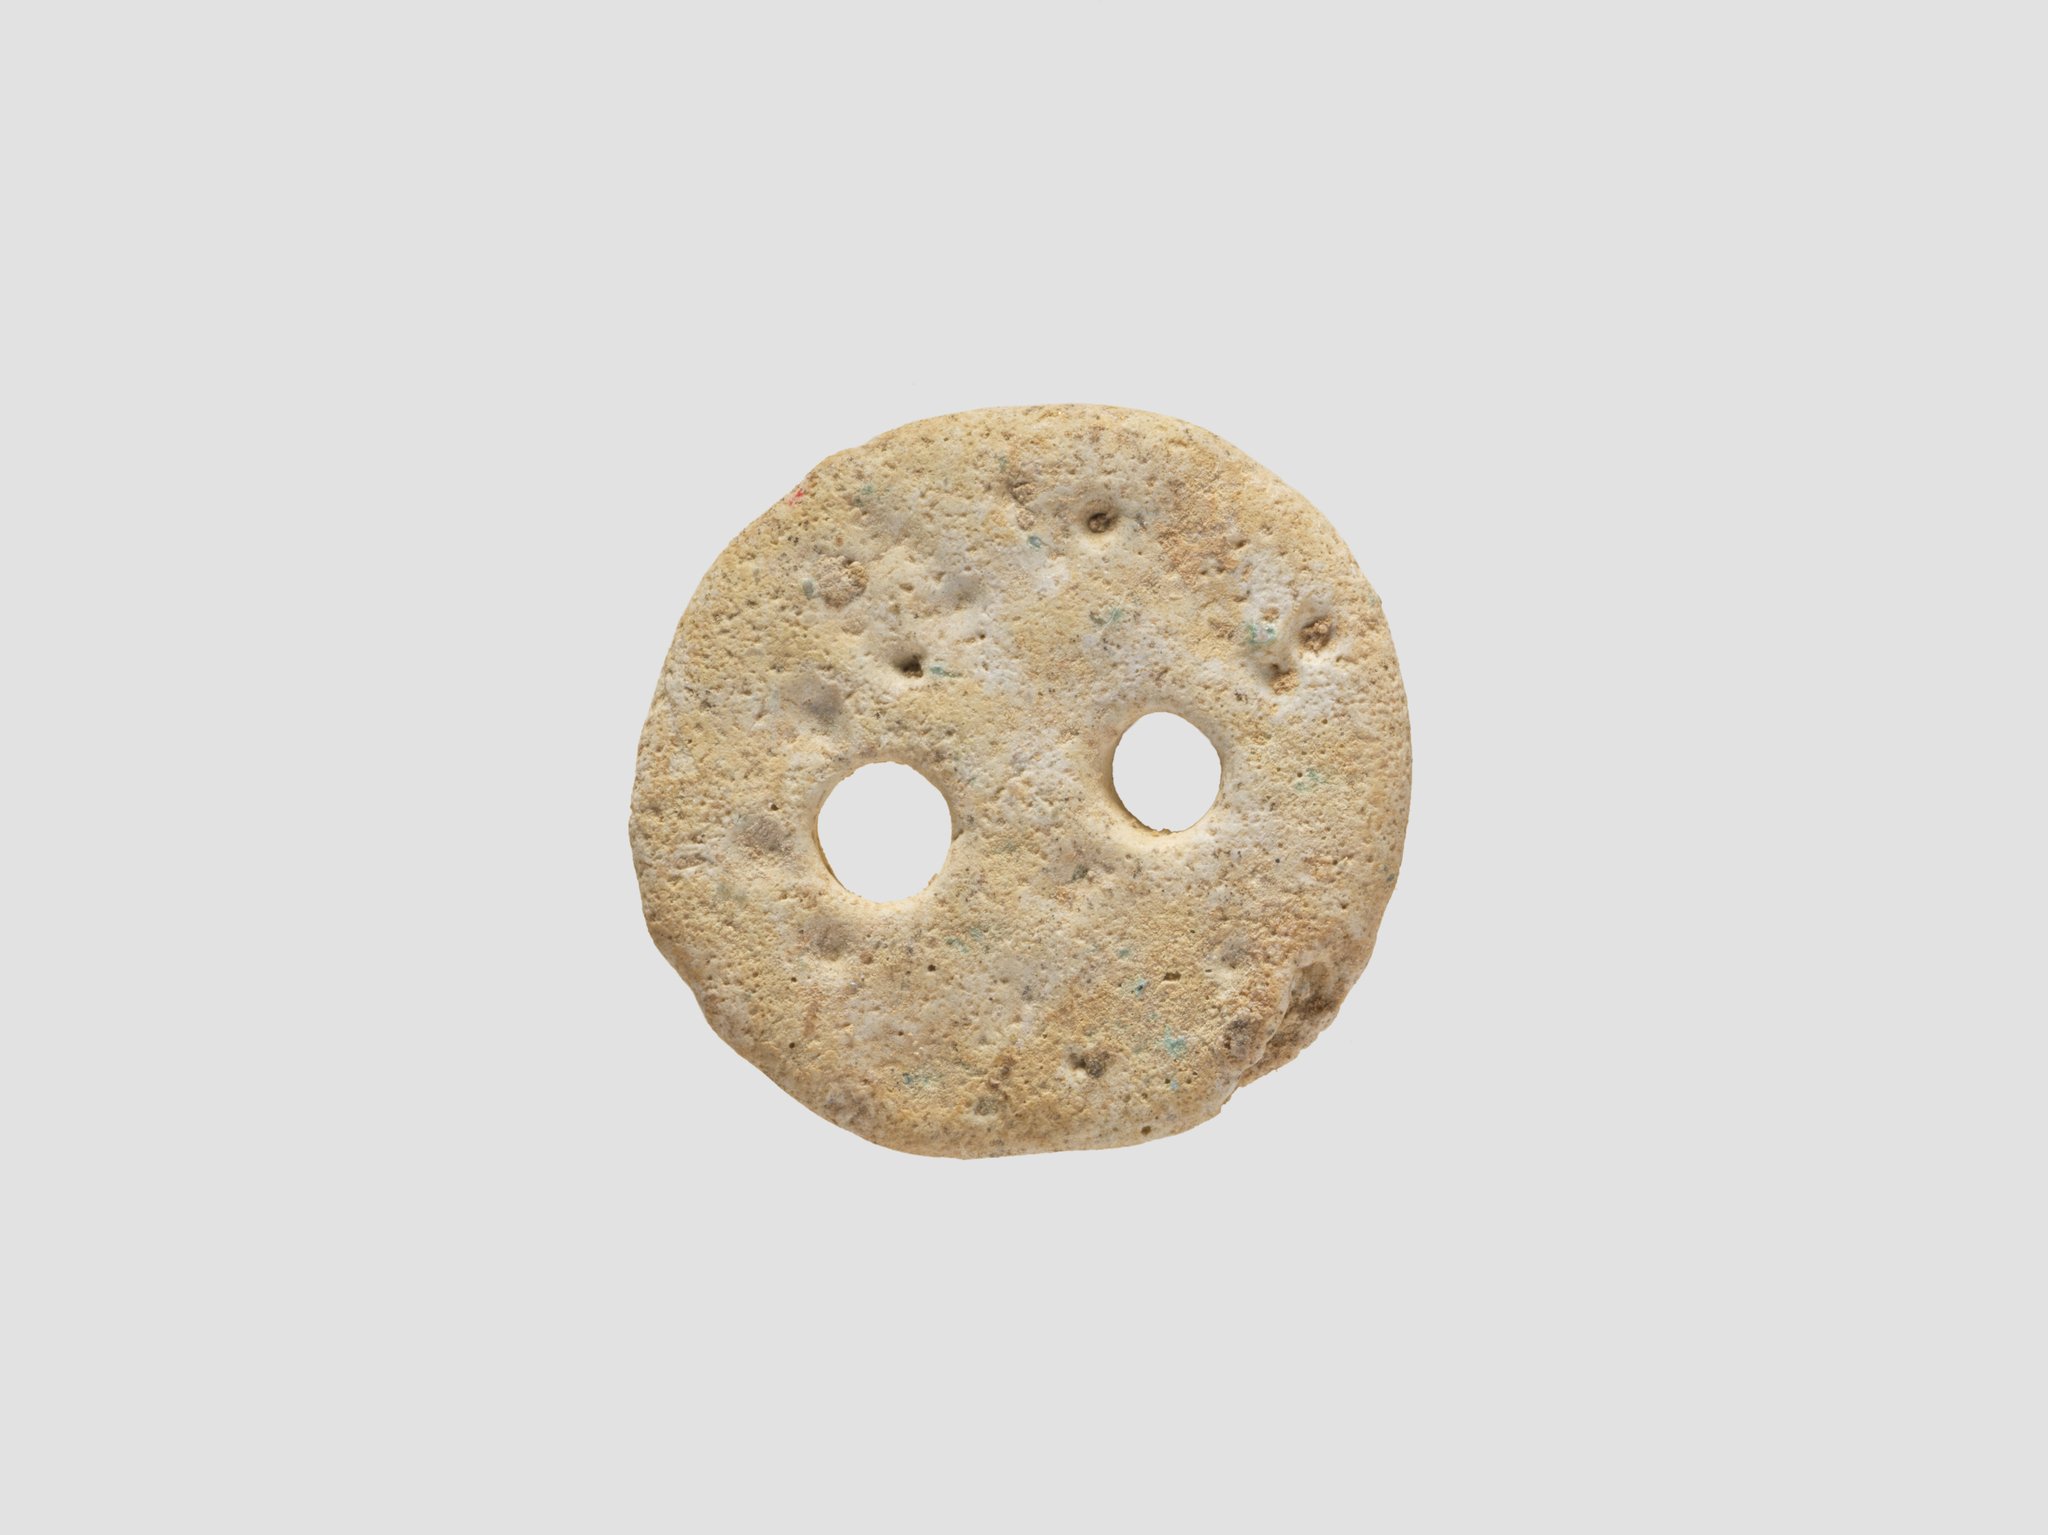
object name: ornament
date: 2333-2001 BCE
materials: faience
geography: mesopotamia